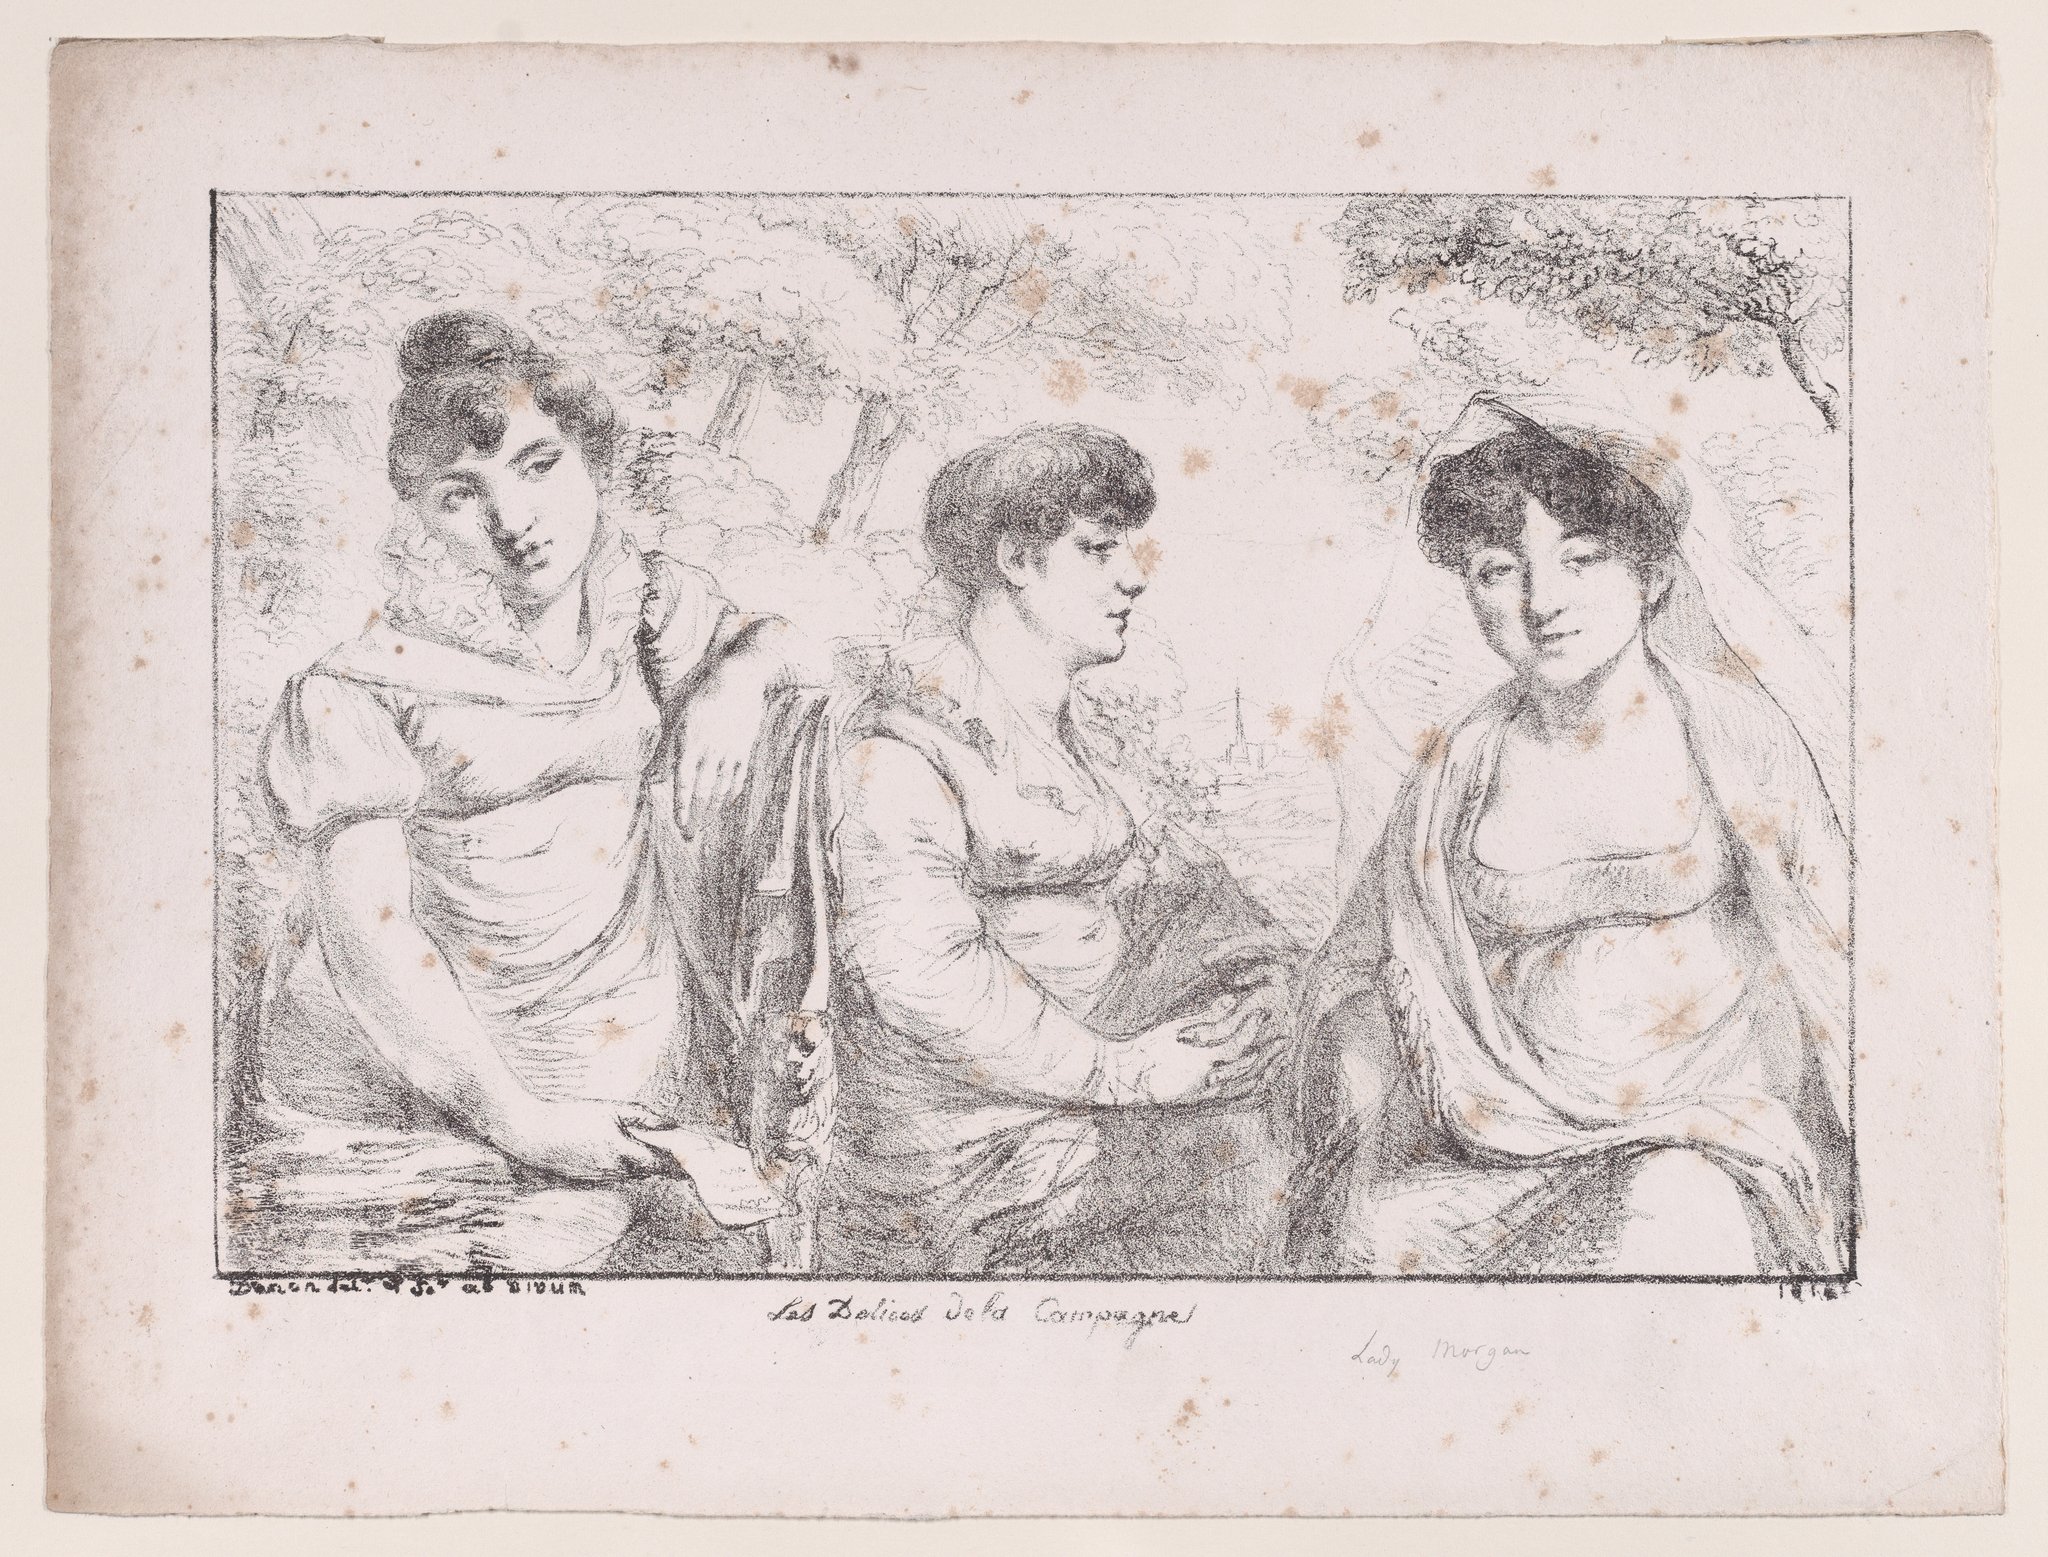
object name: print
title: Les Délices de la Campagne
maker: baron dominique vivant denon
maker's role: artist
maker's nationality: french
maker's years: 1747-1825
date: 1816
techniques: lithograph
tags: women